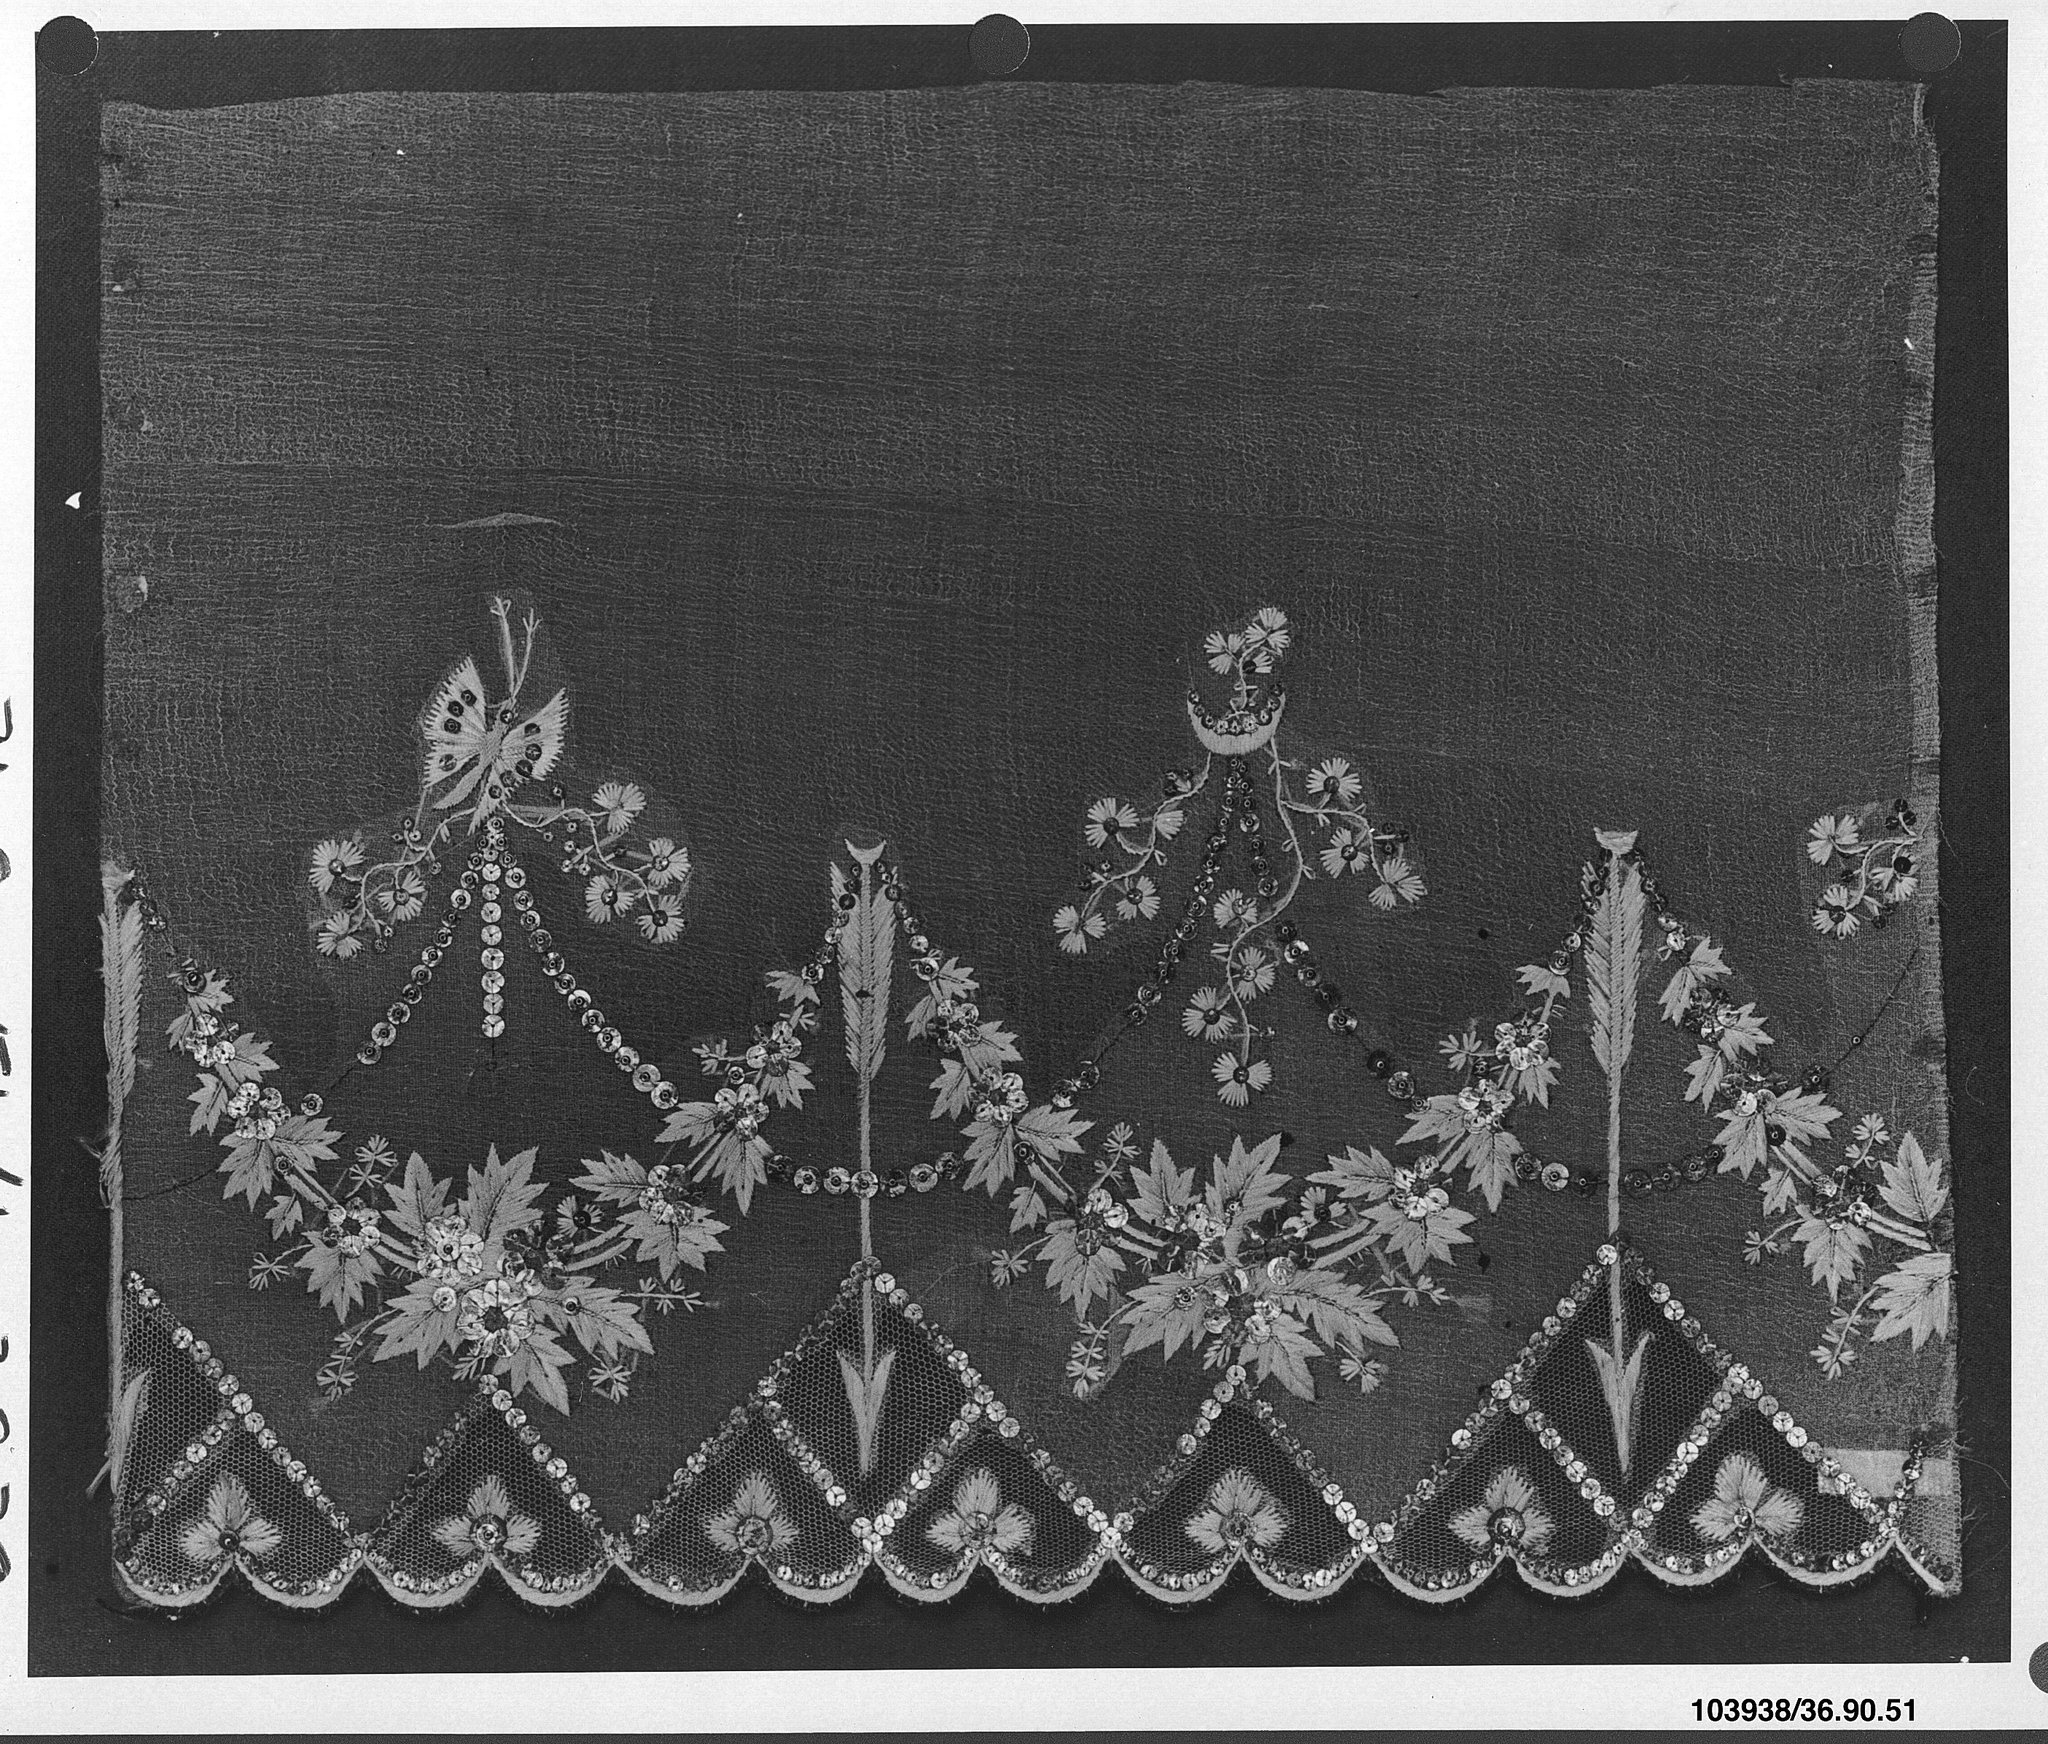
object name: border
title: Dress border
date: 1801-1833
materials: metal, silk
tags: butterflies,flowers